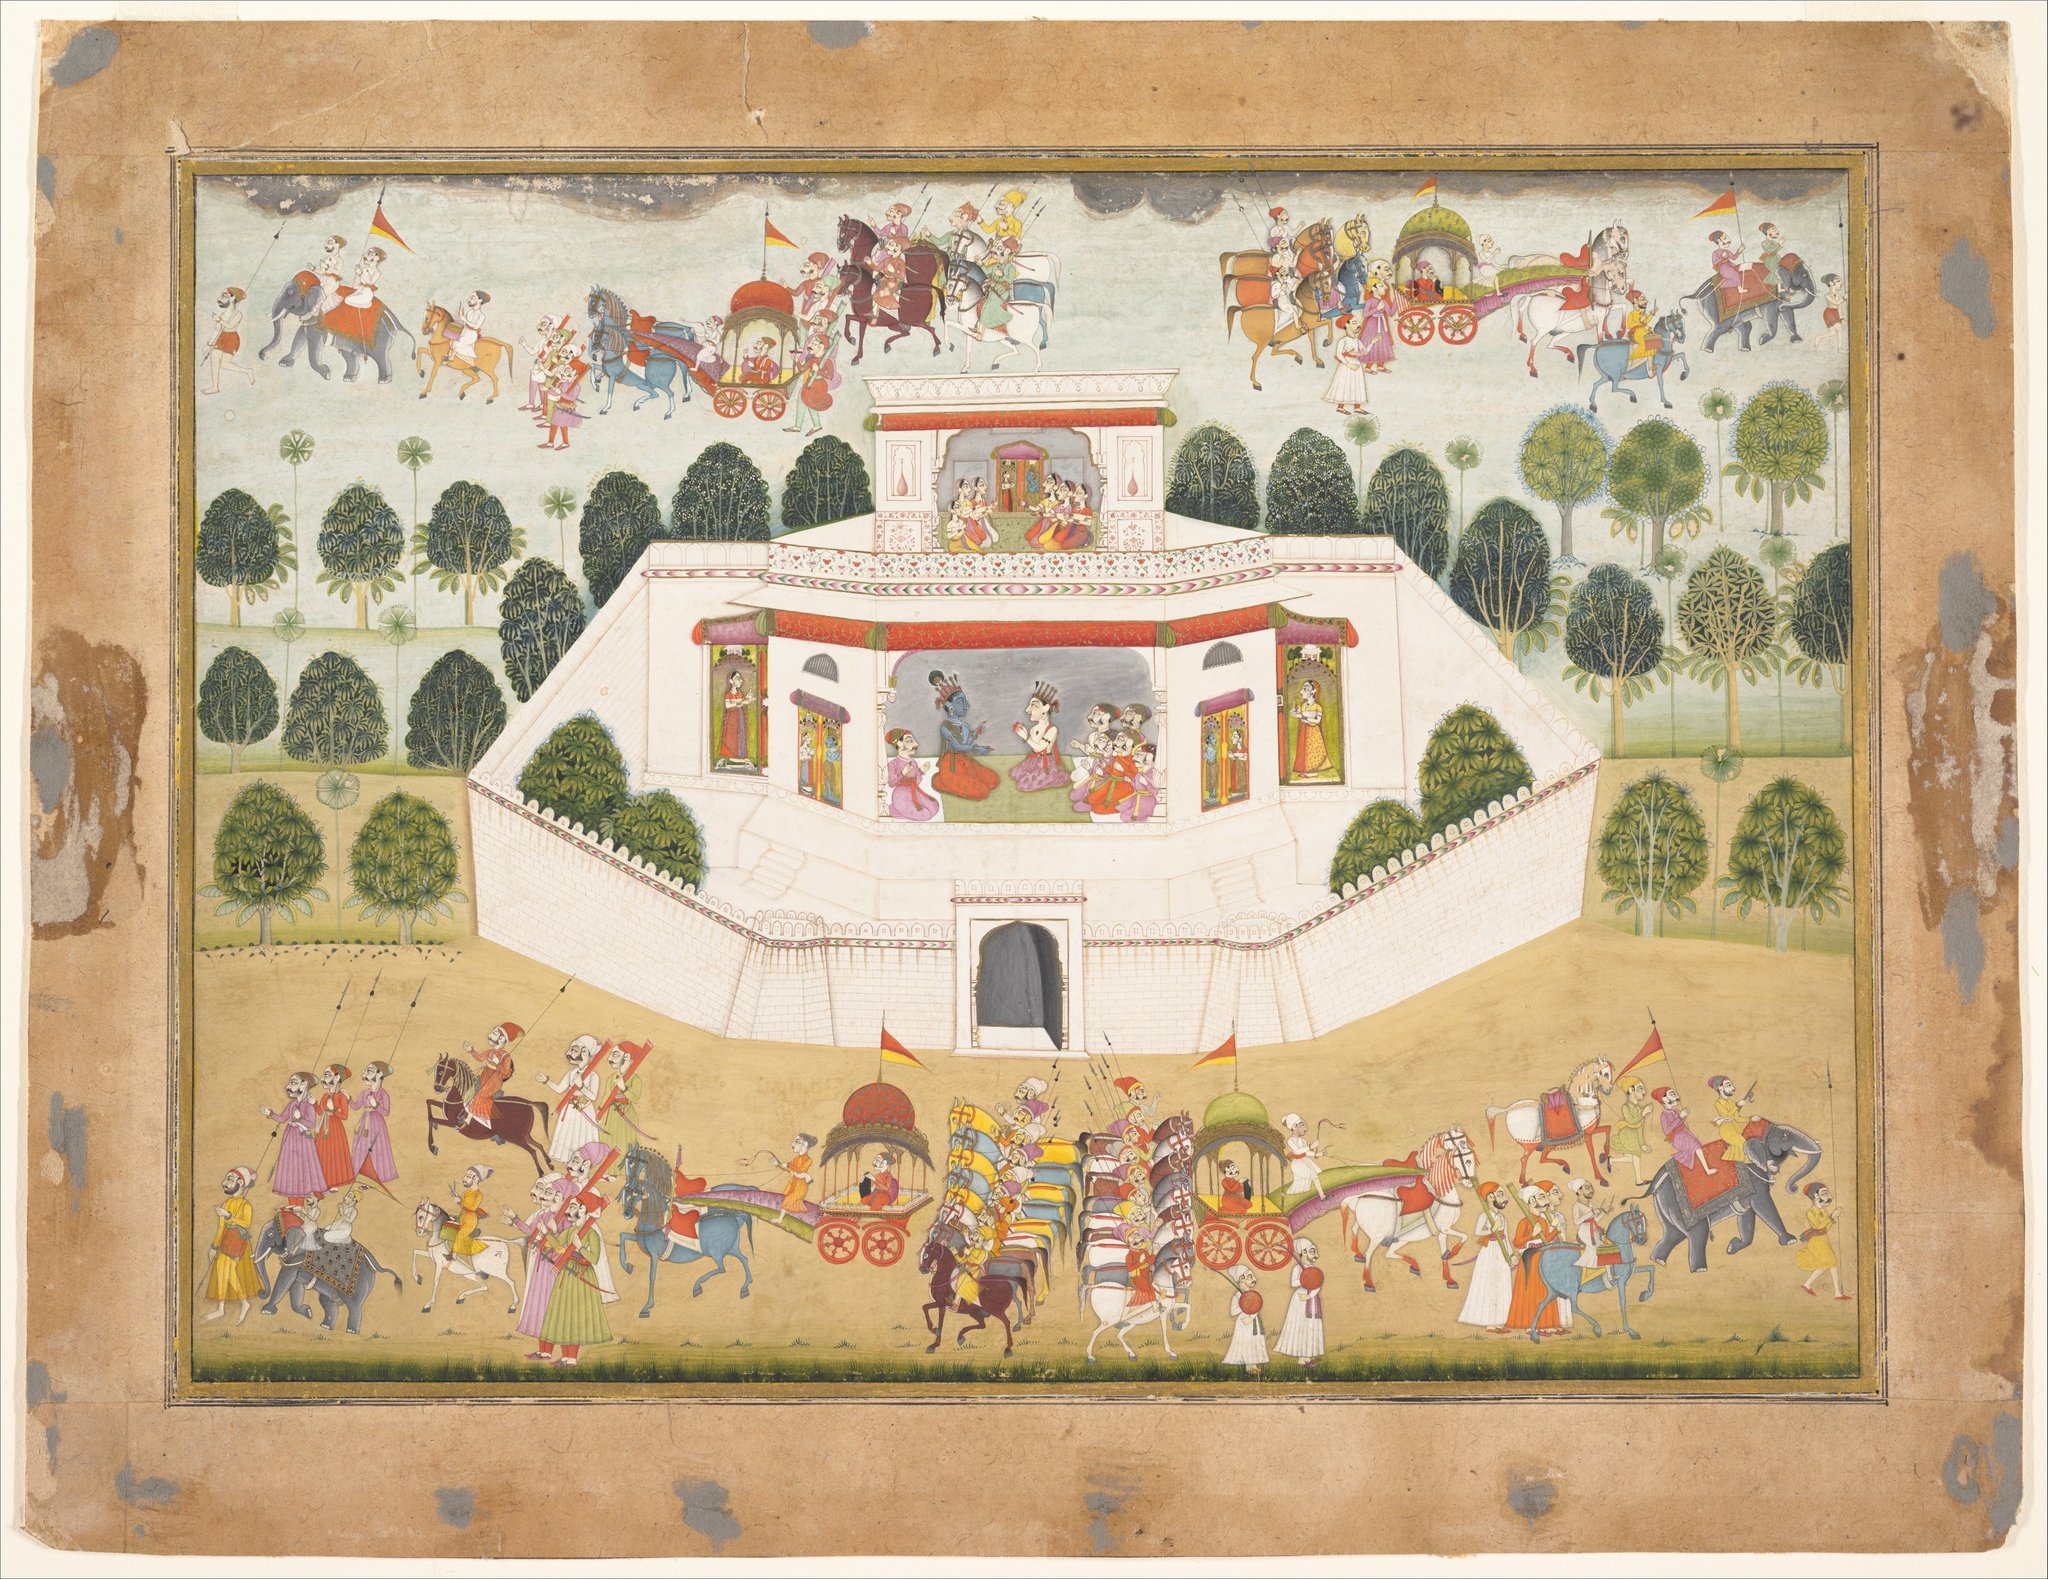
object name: folio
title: Krishna and Balarama within a Walled Palace: Page from a Dispersed Bhagavata Purana (Ancient Stories of Lord Vishnu)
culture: indian, rajasthani, bikaner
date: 1700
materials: ink, paper, watercolor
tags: palaces,elephants,horses,krishna,carriages